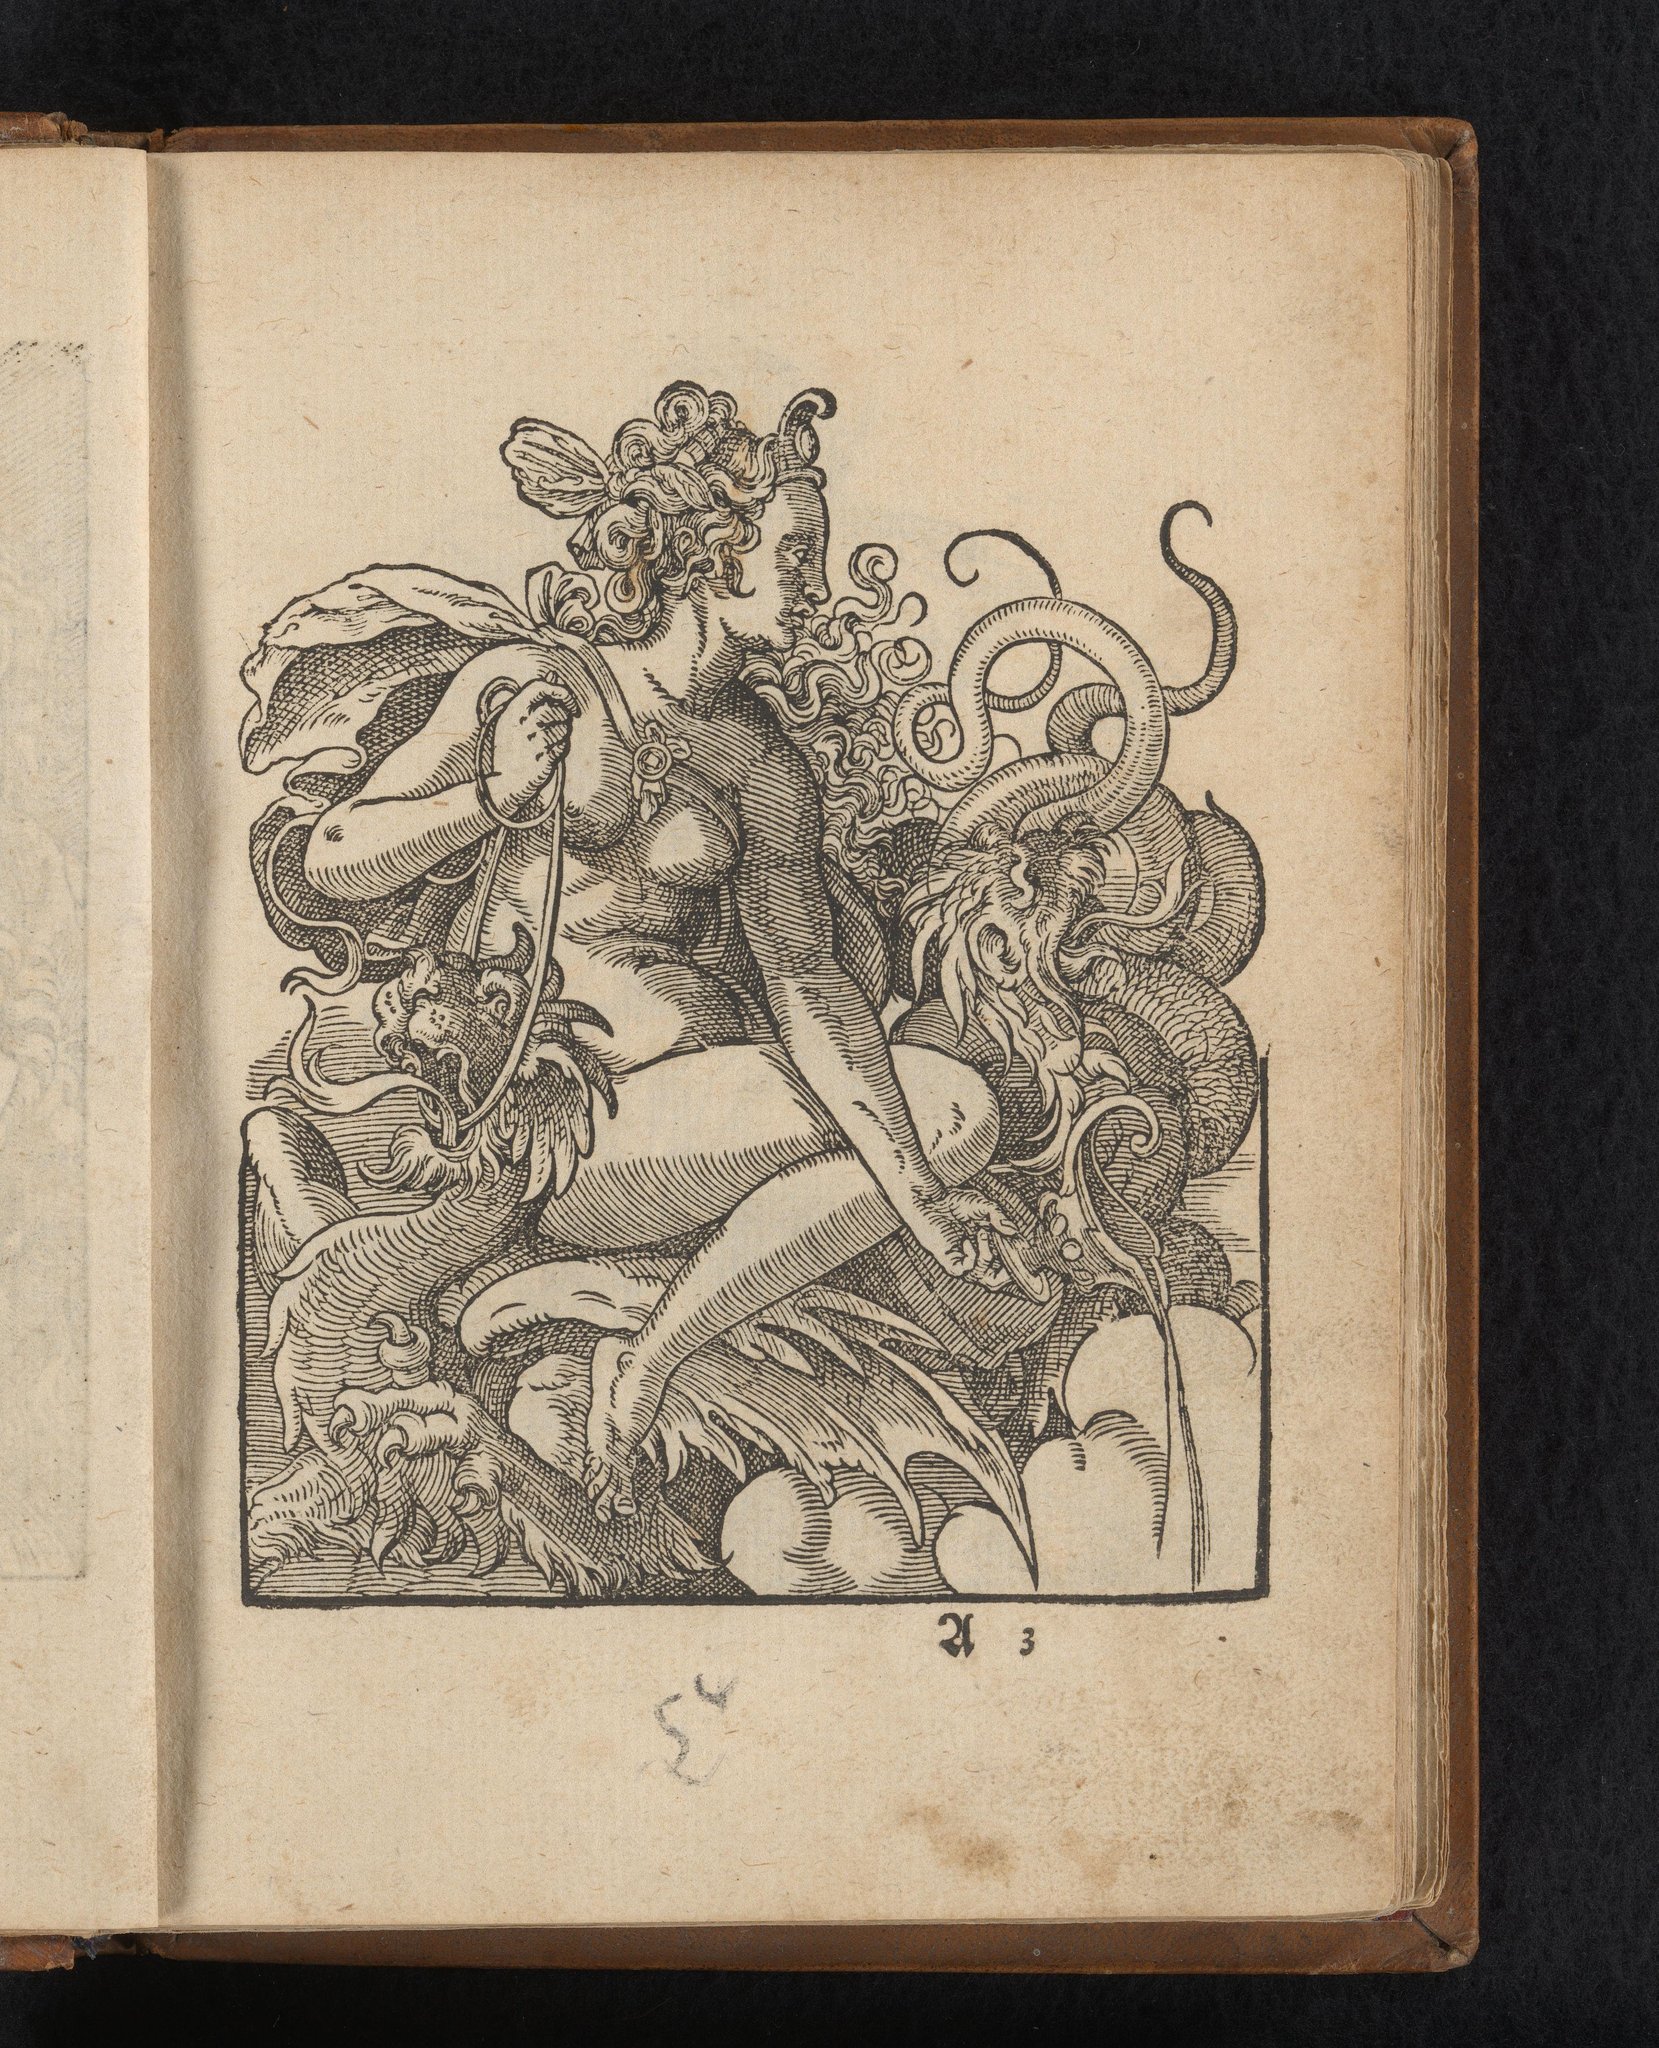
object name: print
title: Medea rijdend op draken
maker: Anonymous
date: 1578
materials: paper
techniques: woodcut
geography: nuremberg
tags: dragon (large fabulous serpent, sometimes with wings and legs), sitting figure - aa - female human figure, medea kills her two children; she flees from corinth in a chariot drawn by winged dragons, dragon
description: Medea rijdend op twee draken in de wolken. Zij giet een vloeistof uit een schaal. Onderdeel van het modelboek Enchiridion artis pingendi, fingendi & sculpendi met 108 figuren bedoeld voor beginnende schilders, beeldhouwers en prentmakers.